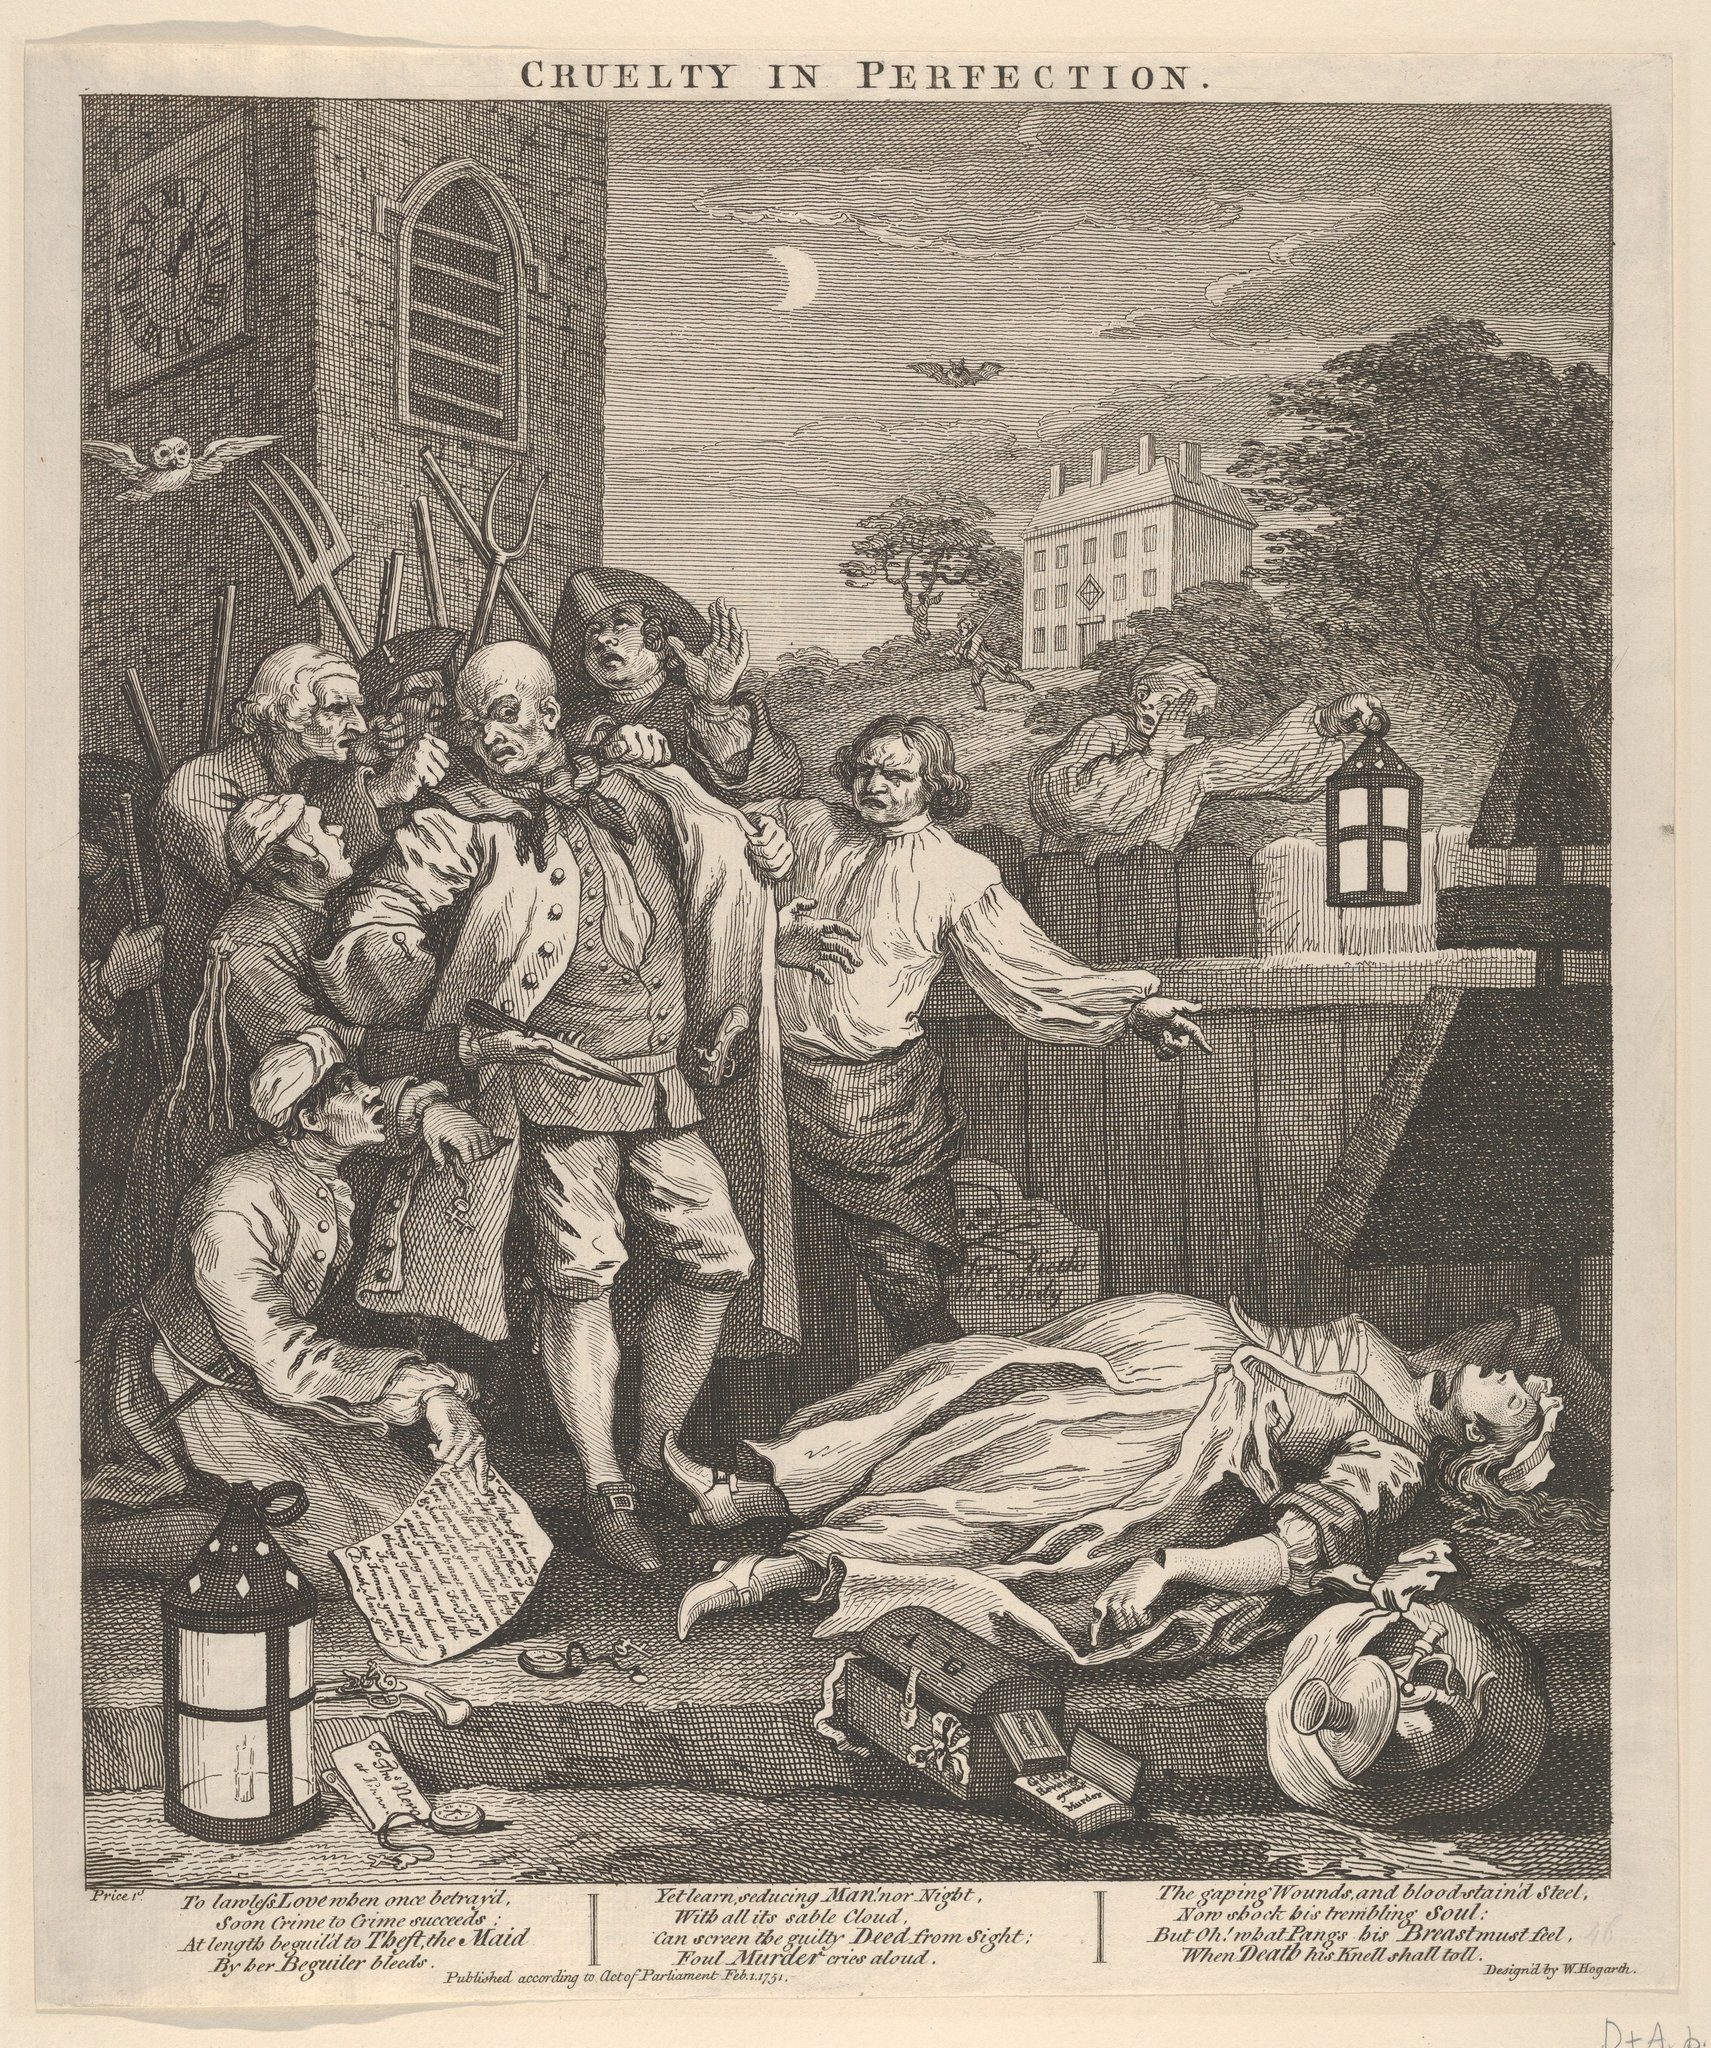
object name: print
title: Cruelty in Perfection (The Four Stages of Cruelty)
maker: william hogarth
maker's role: artist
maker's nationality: british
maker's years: 1697-1764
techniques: engraving, etching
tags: birds,men,women,death